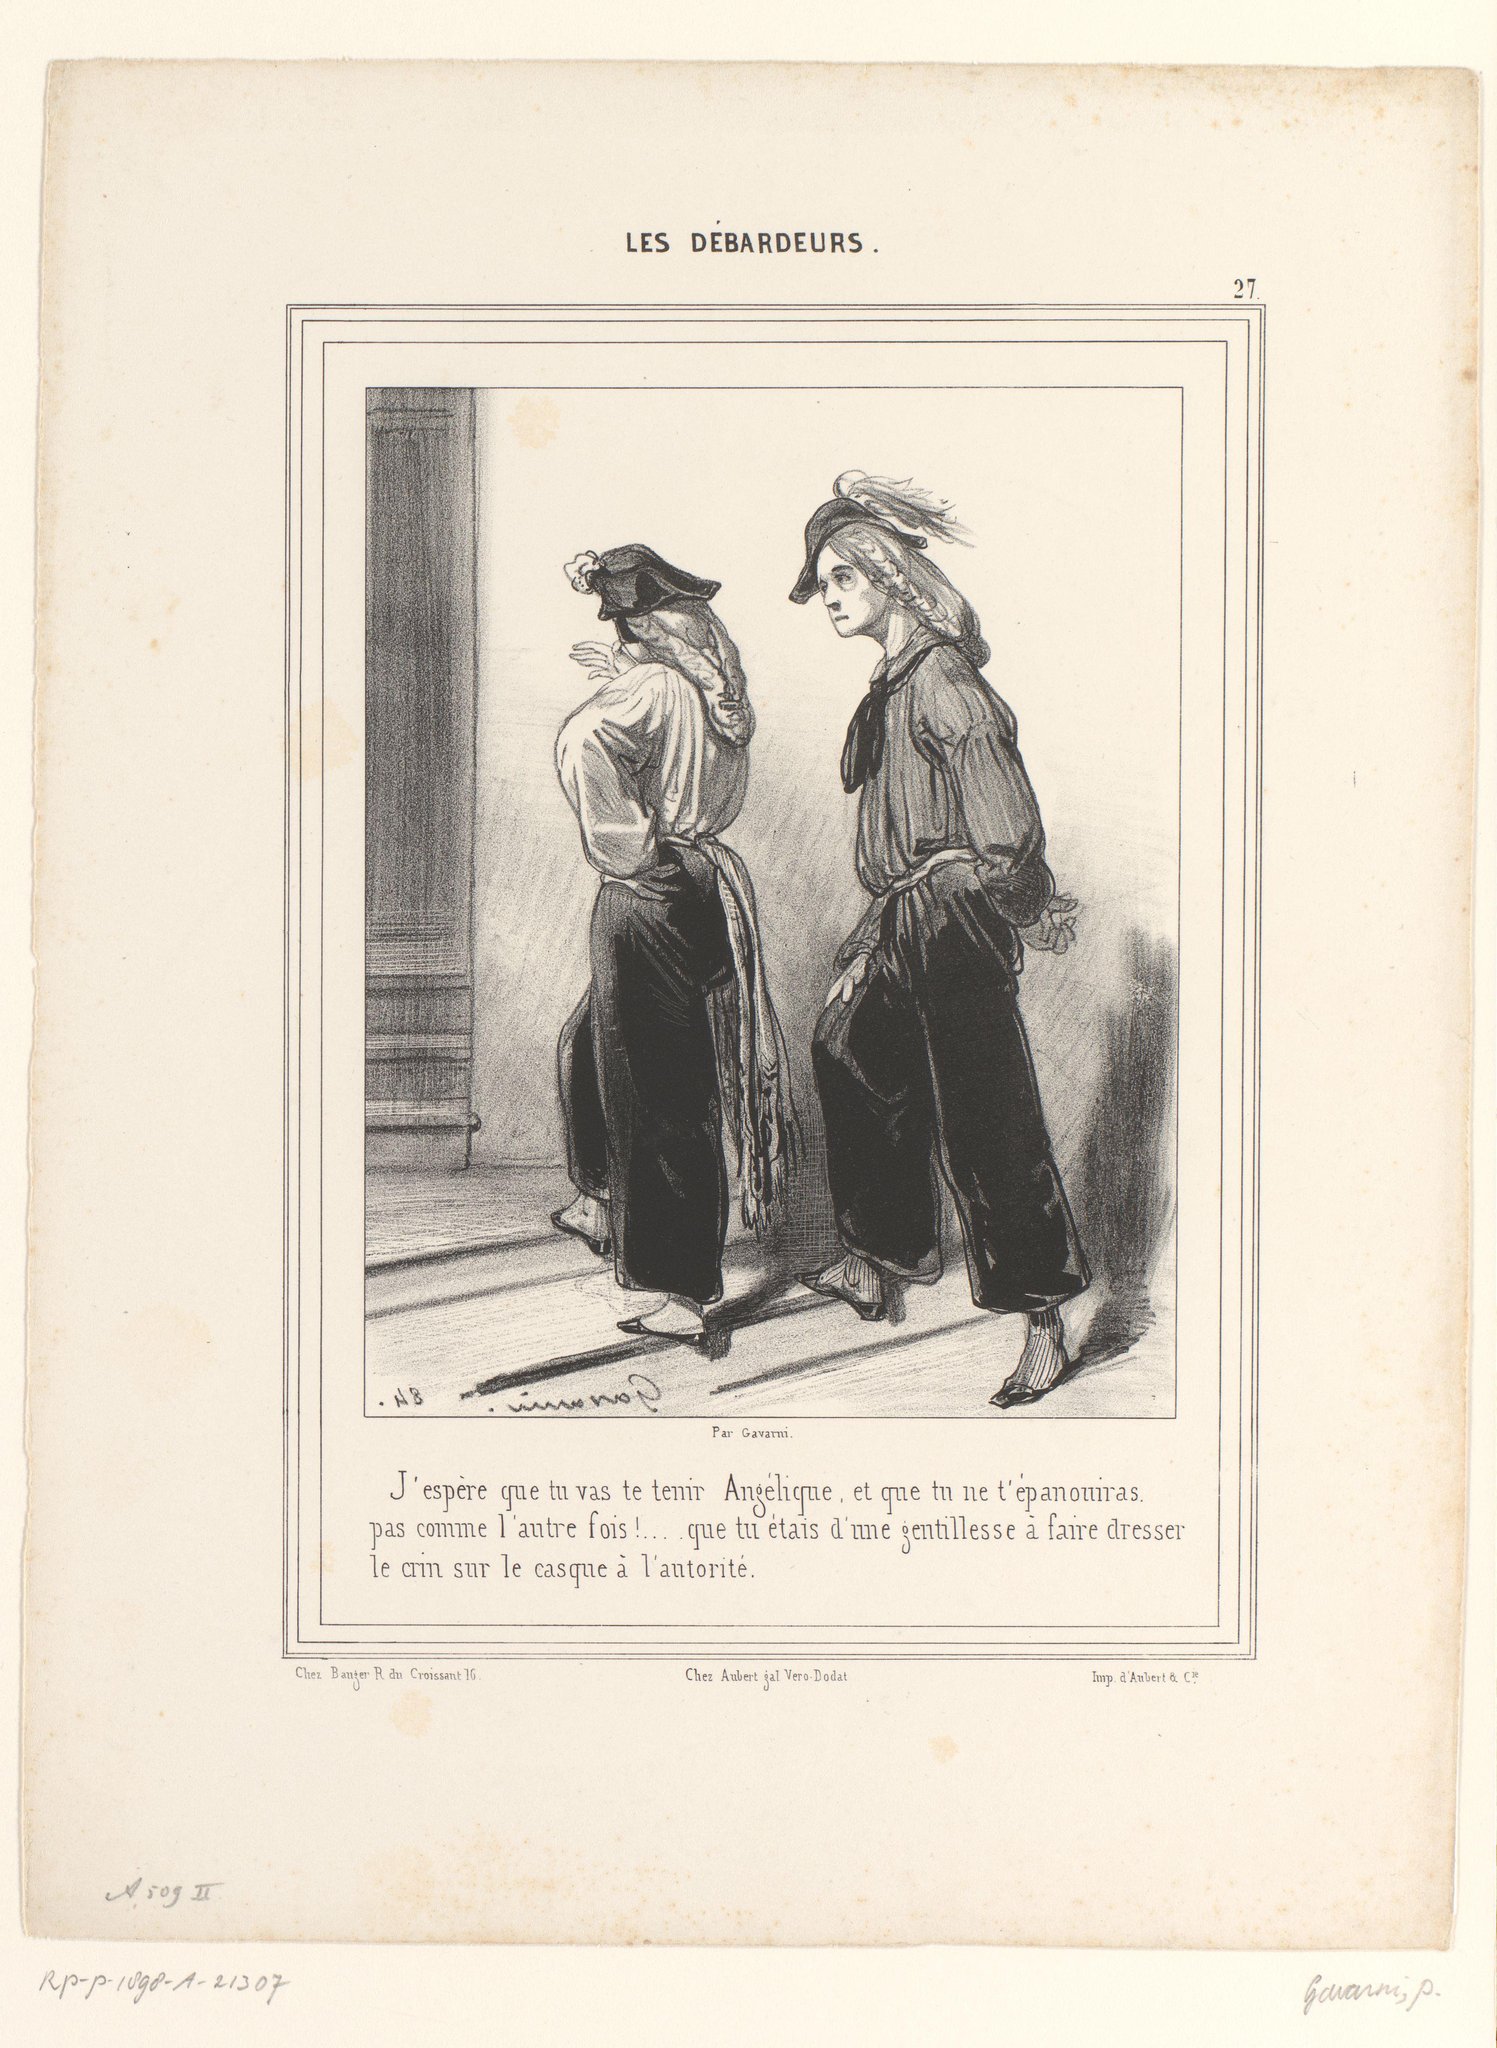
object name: cartoon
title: Modieuze kostuums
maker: paul gavarni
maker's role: draughtsman, print maker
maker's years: 1804-1866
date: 1840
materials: paper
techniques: lithograph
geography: paris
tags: fashion, clothing, party clothes, festive attire, staircase, lovers' tiff, quarrel, sulk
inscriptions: collector's mark: Lugt 964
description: Prent gebruikt voor: Le Charivari, 23 november 1840.